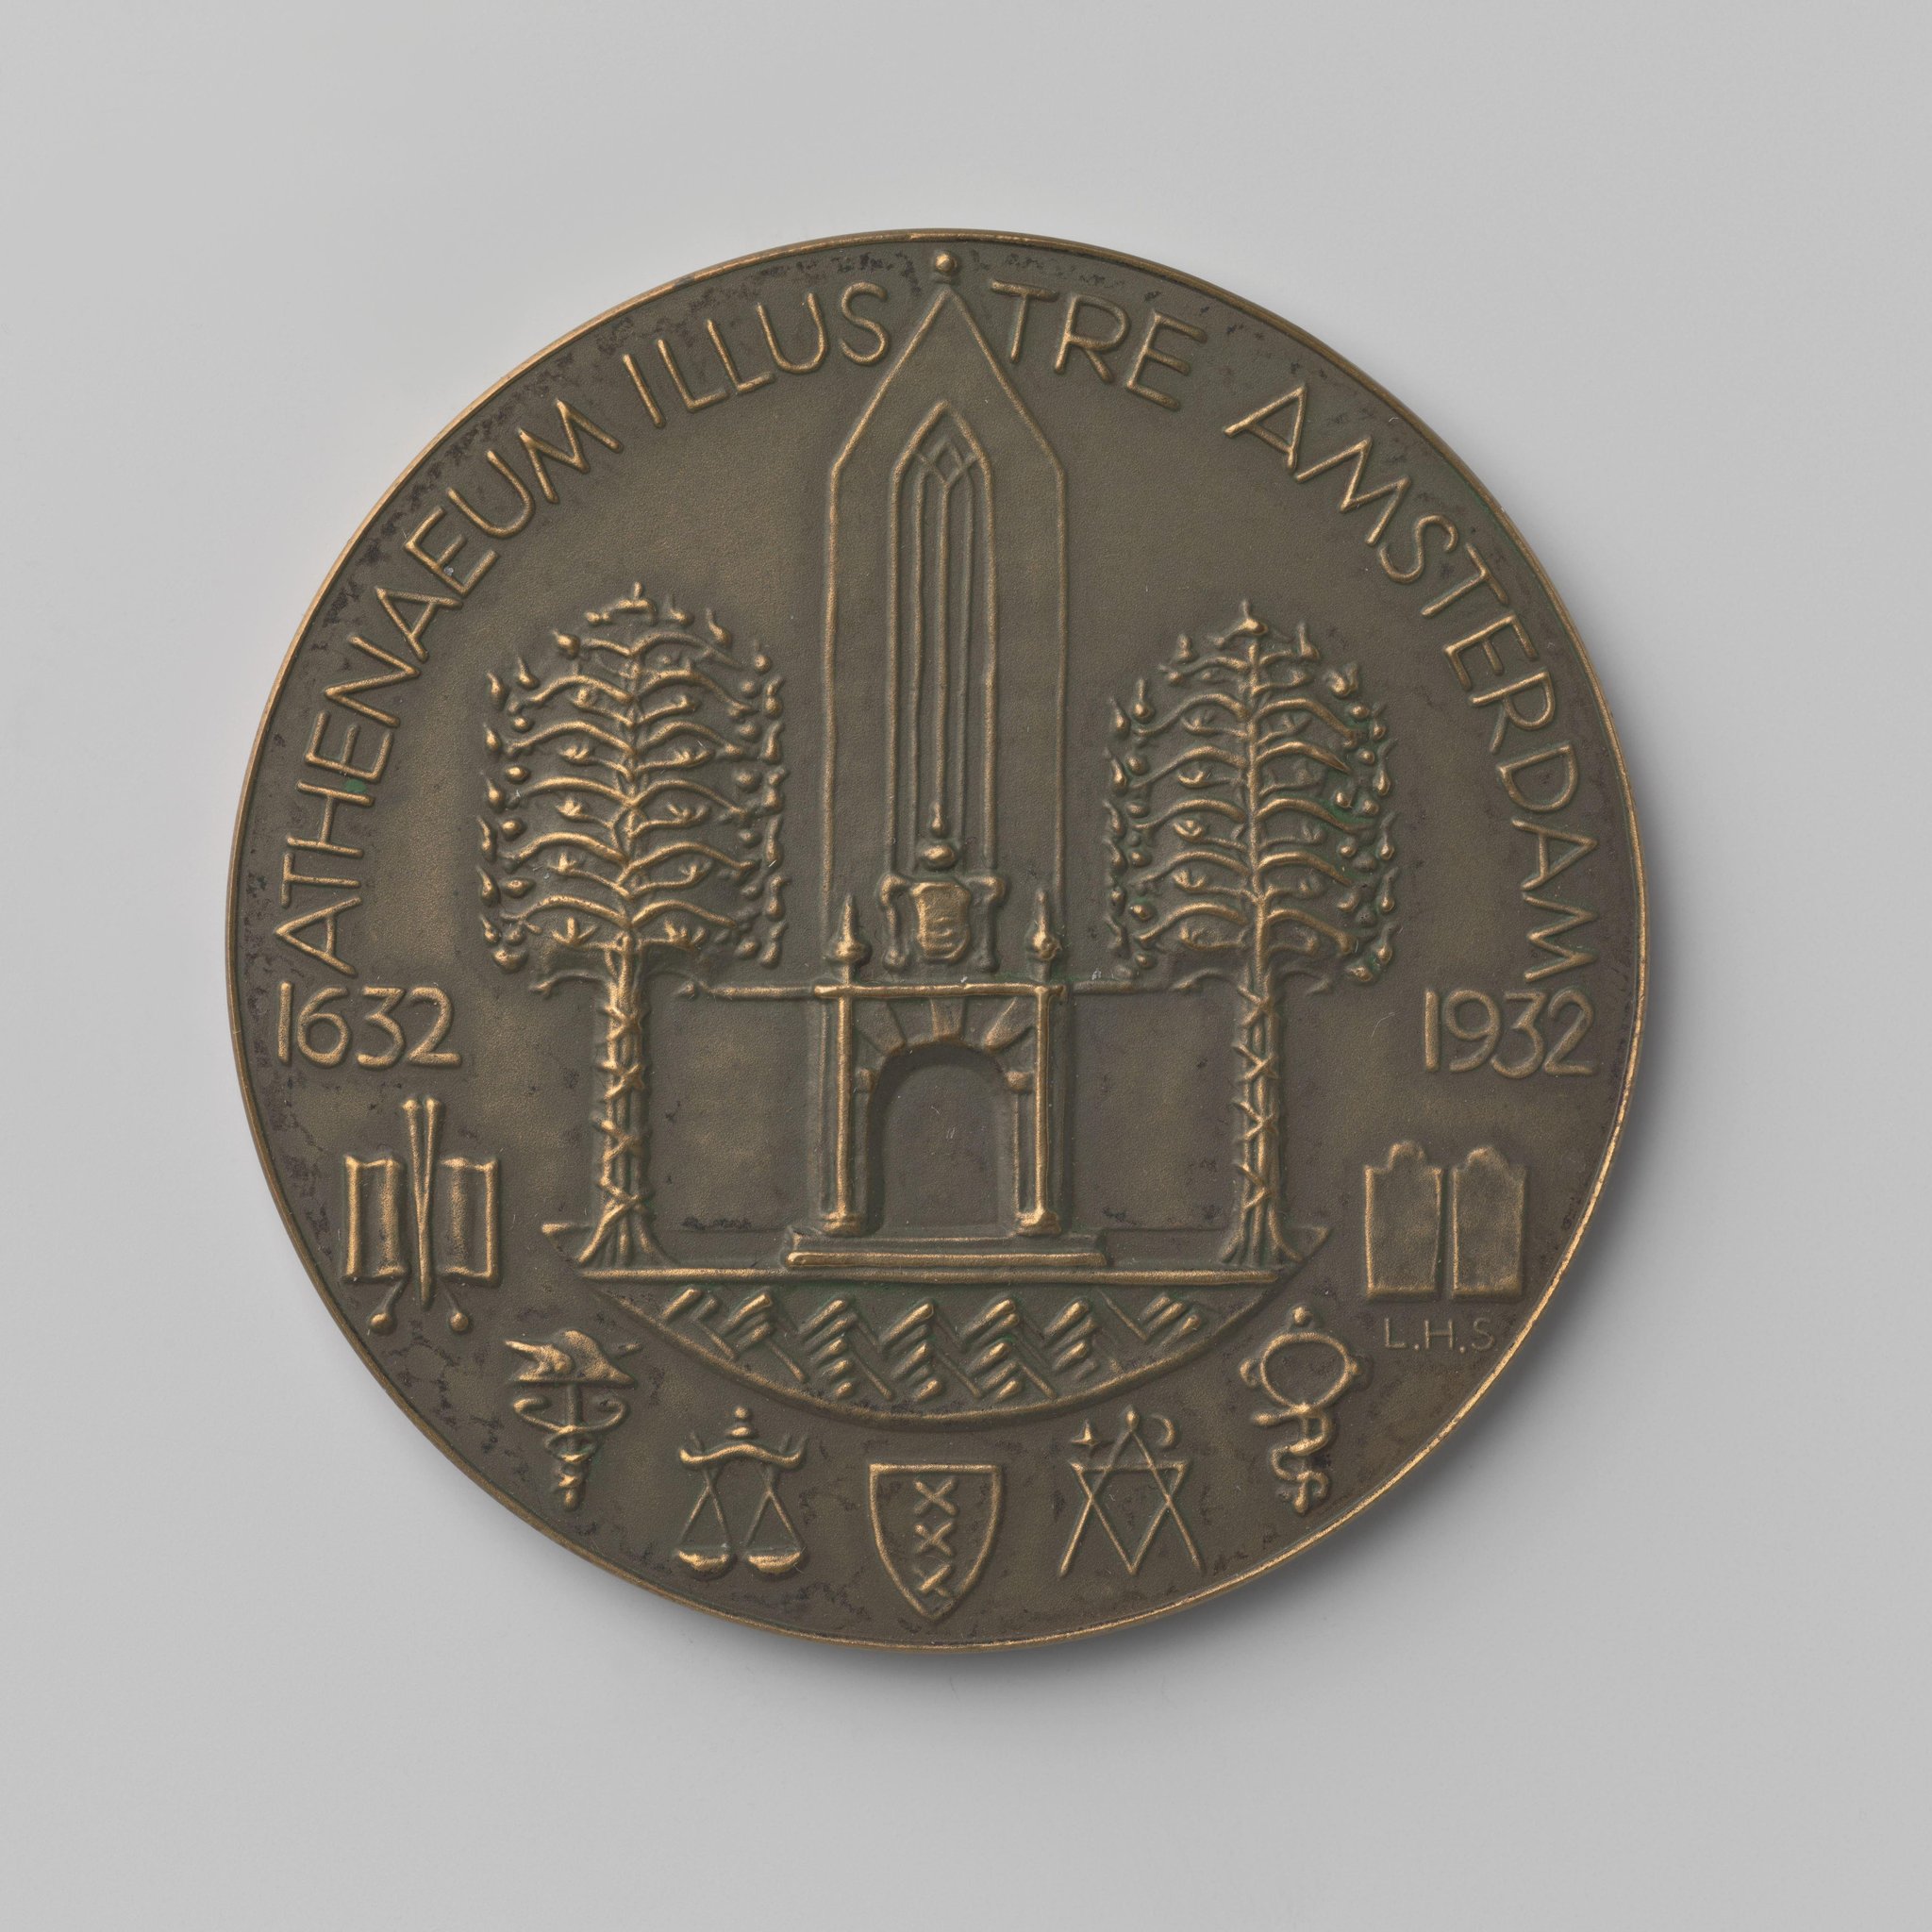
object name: history medal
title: Driehonderd jaar Athenaeum Illustre Amsterdam (Vereniging voor Penningkunst 1932, eerste penning)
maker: bertus sondaar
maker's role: sculptor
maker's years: 1904-1984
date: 1932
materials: bronze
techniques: striking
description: Bronzen penning, op de voorzijde een kapel waarvoor een poort tussen twee bomen en twee jaartallen, met boven omschrift en onderaan het Amsterdamse stadswapenschild te midden van symbolen van de faculteiten, op de keerzijde een brandende olielamp met omschrift, met verklaring.